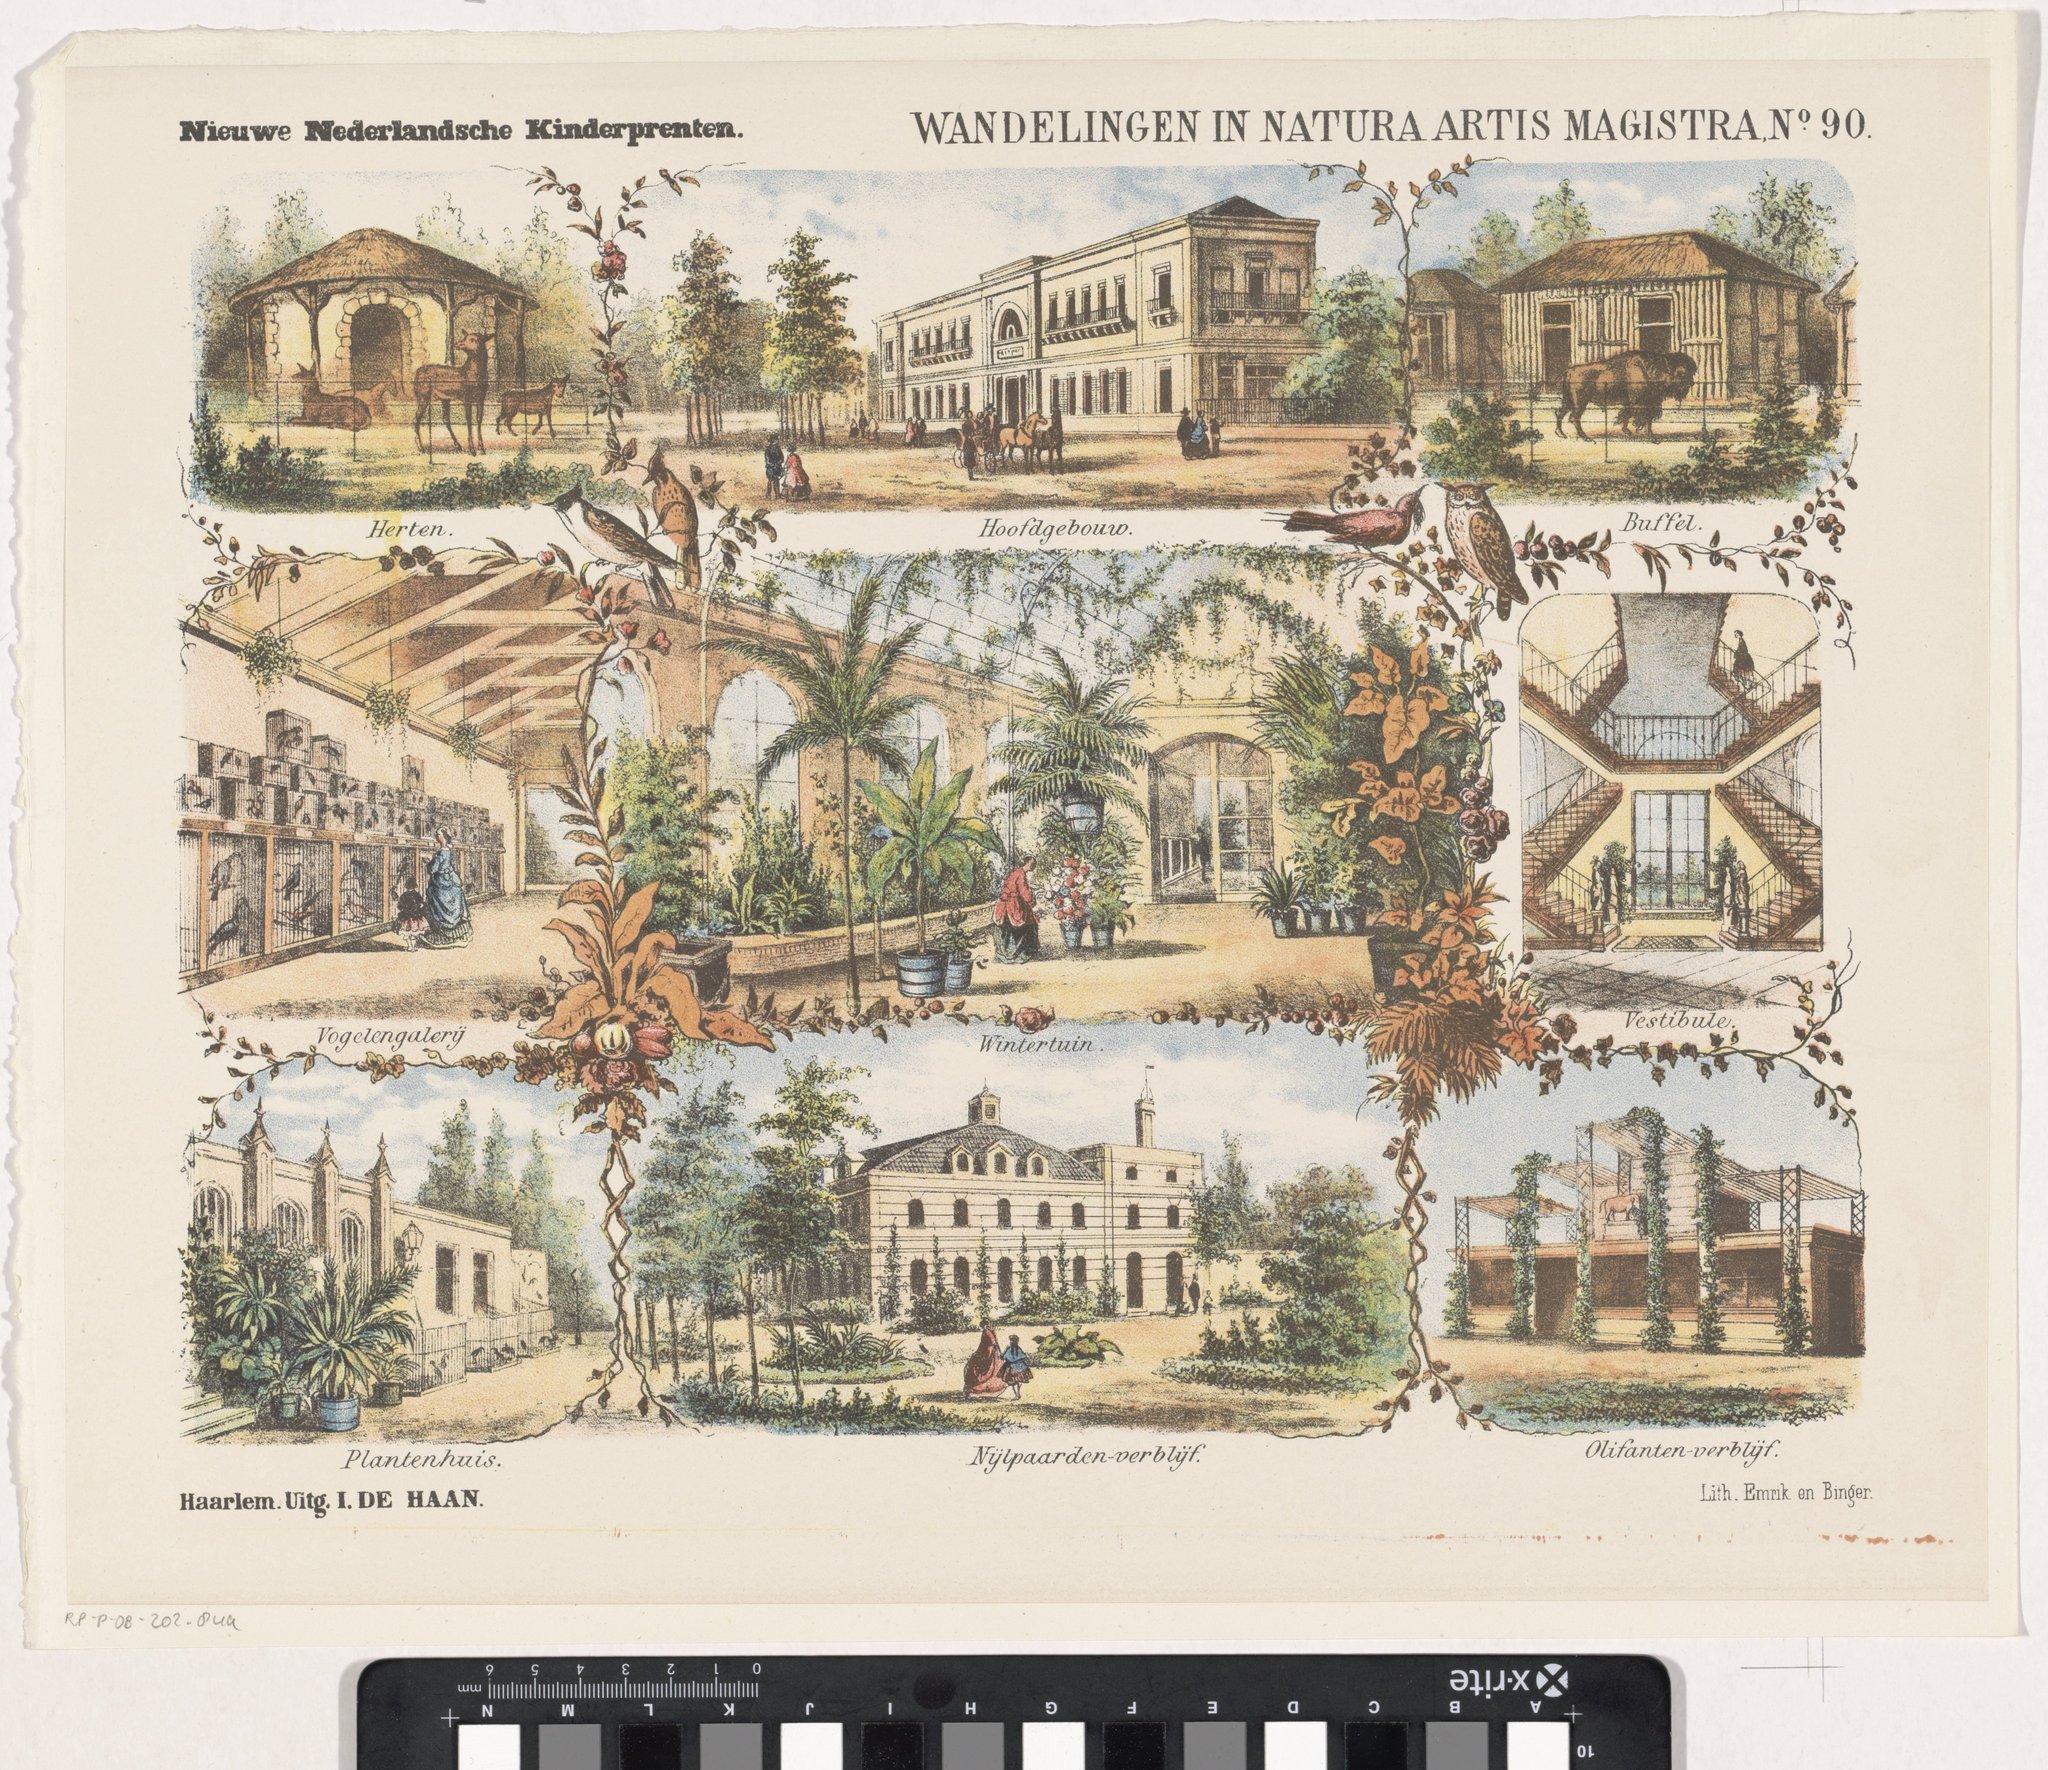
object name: print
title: Nieuwe Nederlandsche kinderprenten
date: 1875-1903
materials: paper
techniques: lithograph, letterpress printing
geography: haarlem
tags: zoological garden, zoo, seen as place where non-domestic animals are kept, zoo (as place of recreation)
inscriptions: collector's mark: Lugt 2760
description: Blad met 9 voorstellingen van gebouwen en dierenverblijven in de dierentuin Natura Artis Magistra, waaronder voorstellingen van het hoofdgebouw, de wintertuin en het nijlpaardenverblijf. Onder elke afbeelding een onderschrift. Genummerd rechtsboven: No. 90.